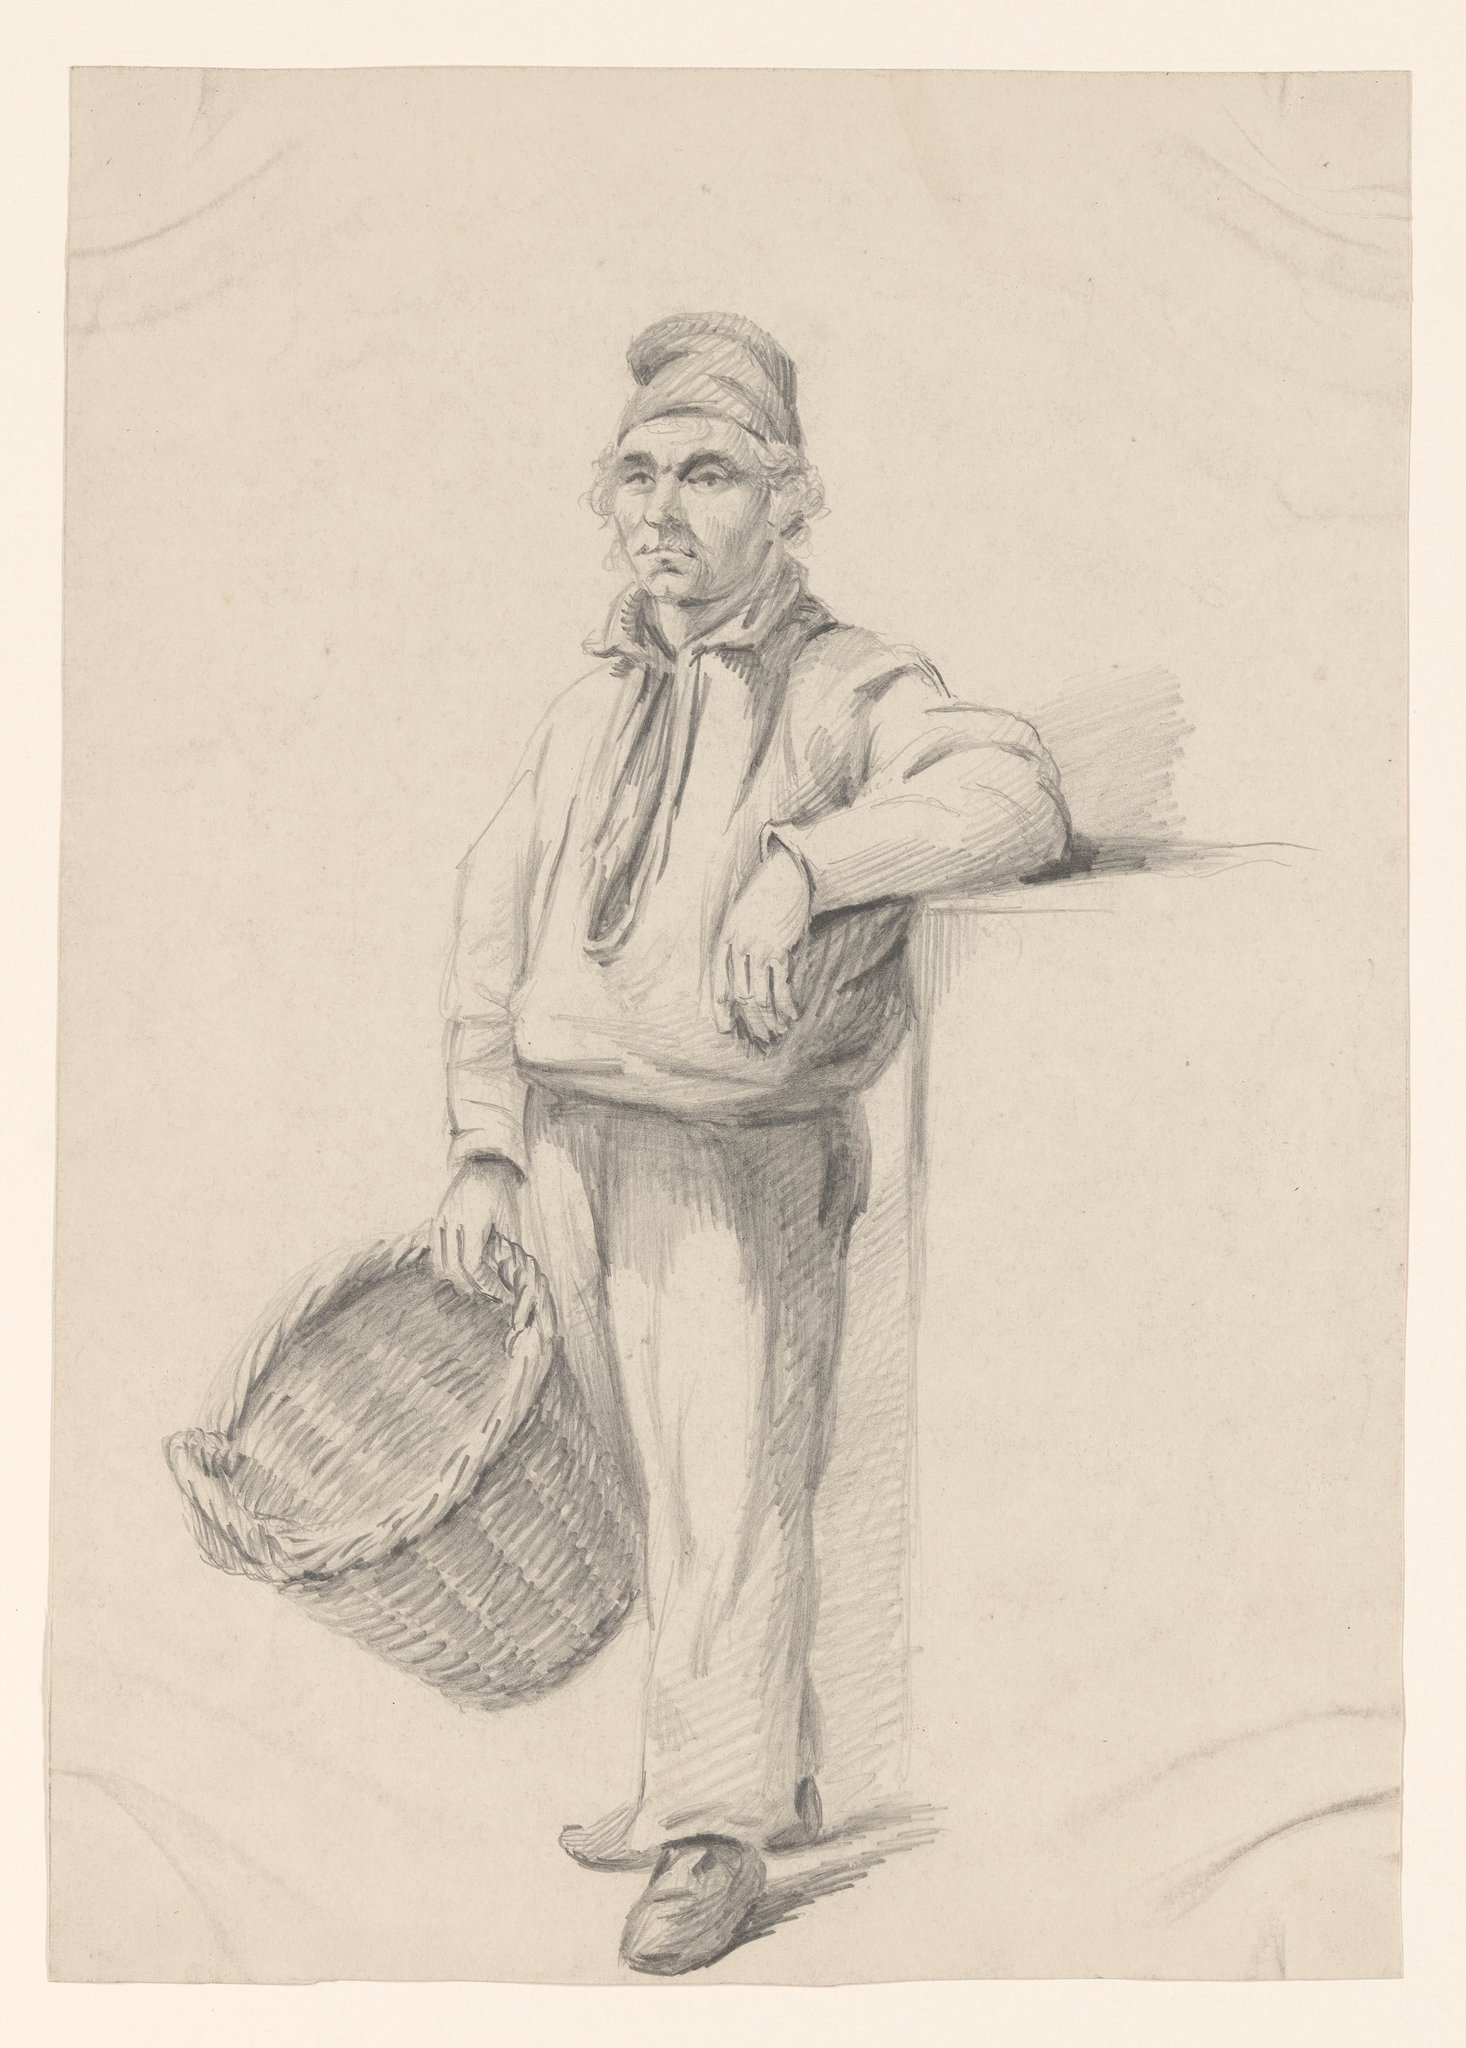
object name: drawing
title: Staande visser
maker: alexander cranendoncq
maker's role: draughtsman, print maker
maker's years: 1799-1869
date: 1809-1869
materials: paper, pencil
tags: fisherman